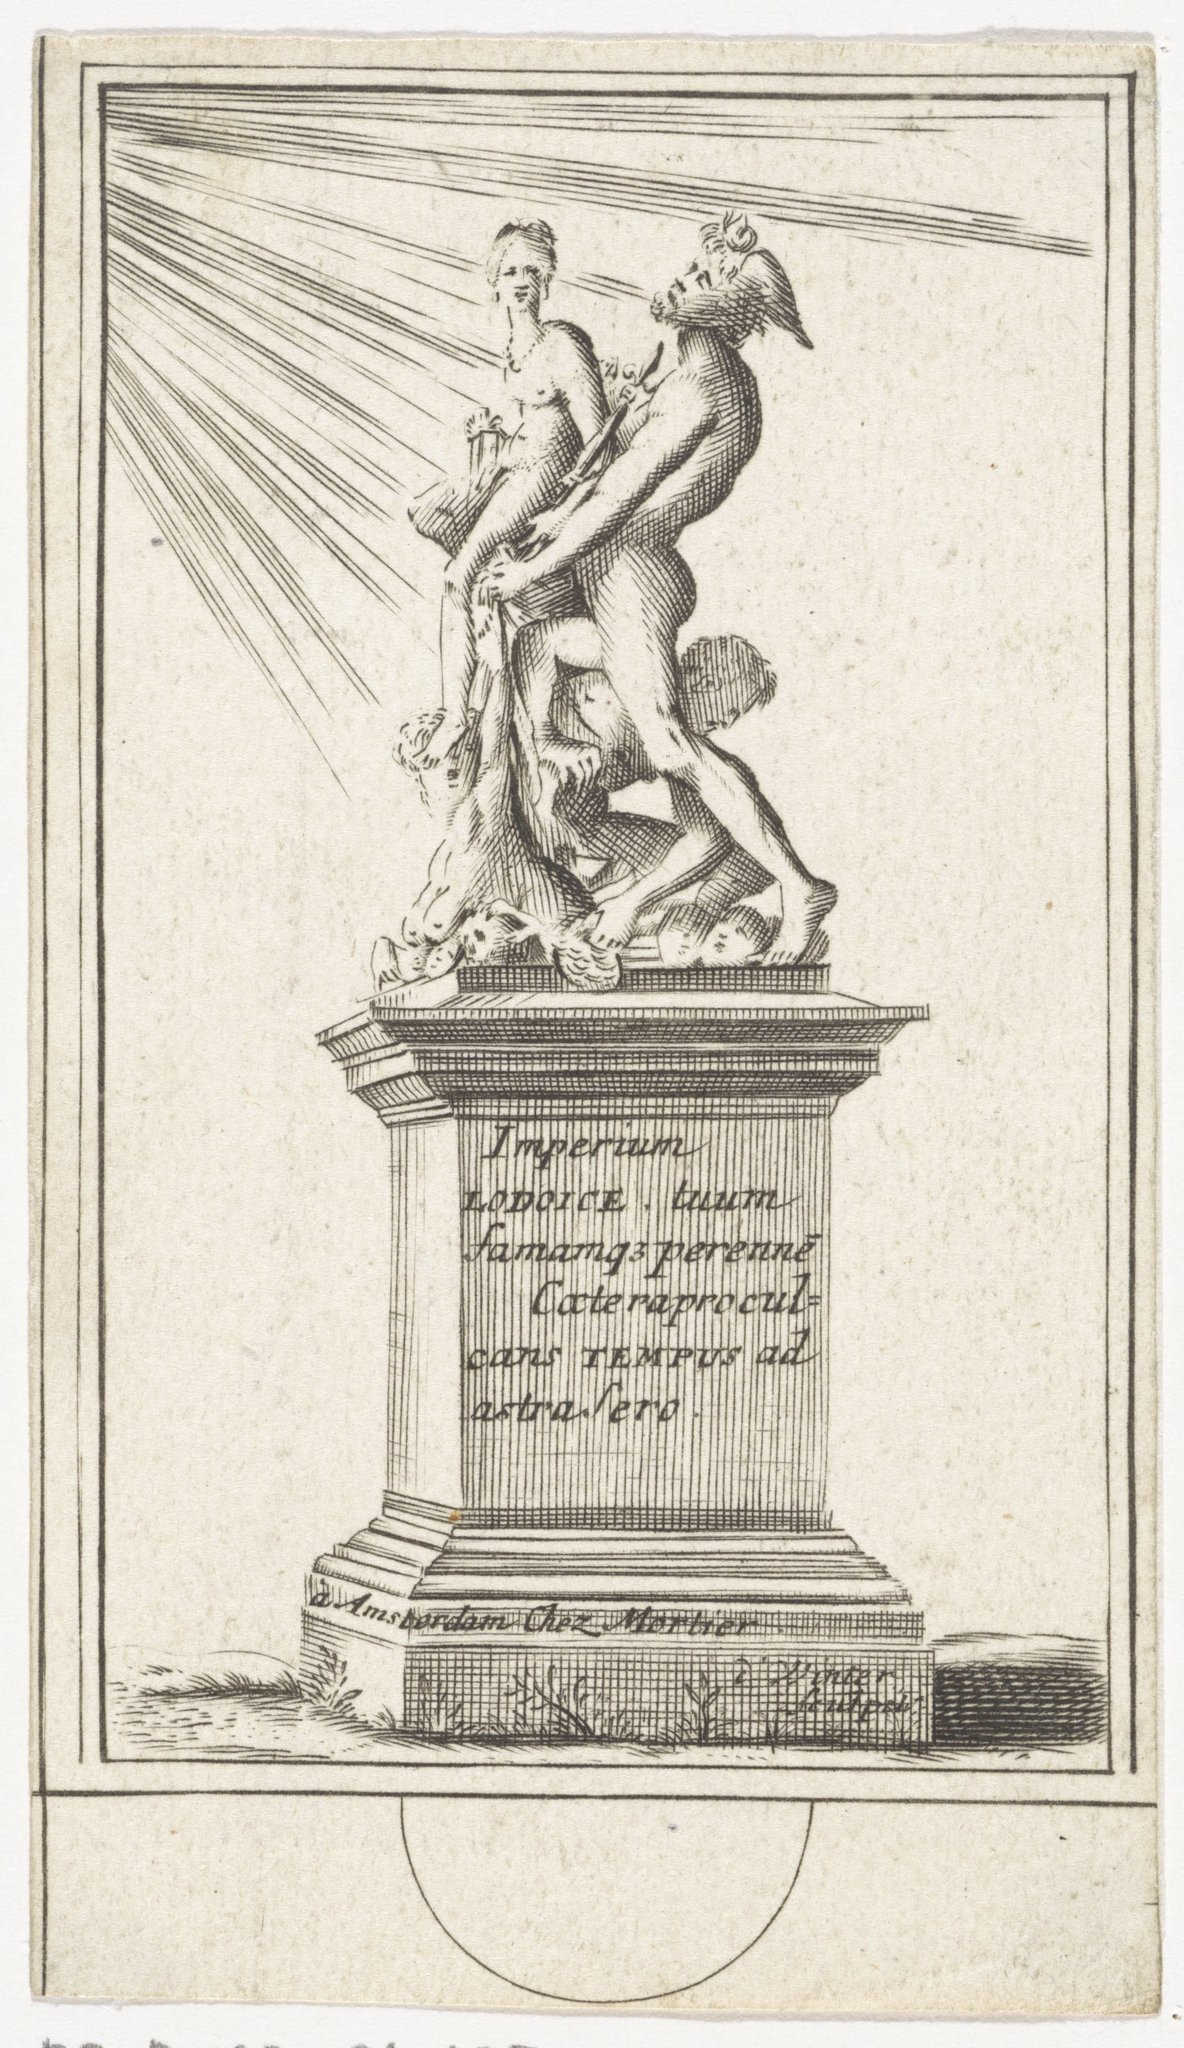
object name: print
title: Vignet met een allegorie op de heerschappij van Lodewijk XIV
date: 1668-1707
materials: paper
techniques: engraving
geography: amsterdam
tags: personifications of countries, nations, states, districts, etc., piece of sculpture, reproduction of a piece of sculpture, allegory of time and eternity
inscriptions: collector's mark: Lugt 2228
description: Op een sokkel zit de personificatie van Frankrijk met een schild en een scepter met een fleur-de-lys op de schoot van de personificatie van tijd in de gedaante van een man met vleugels op zijn hoofd. Hij vertrapt enkele kwaadwillende figuren, onder wie de personificatie van afgunst(?), en toont de personificatie van Frankrijk aan de zon. Op de sokkel staat een Latijnse tekst over de voorspoed van Frankrijk onder de heerschappij van Lodewijk XIV.